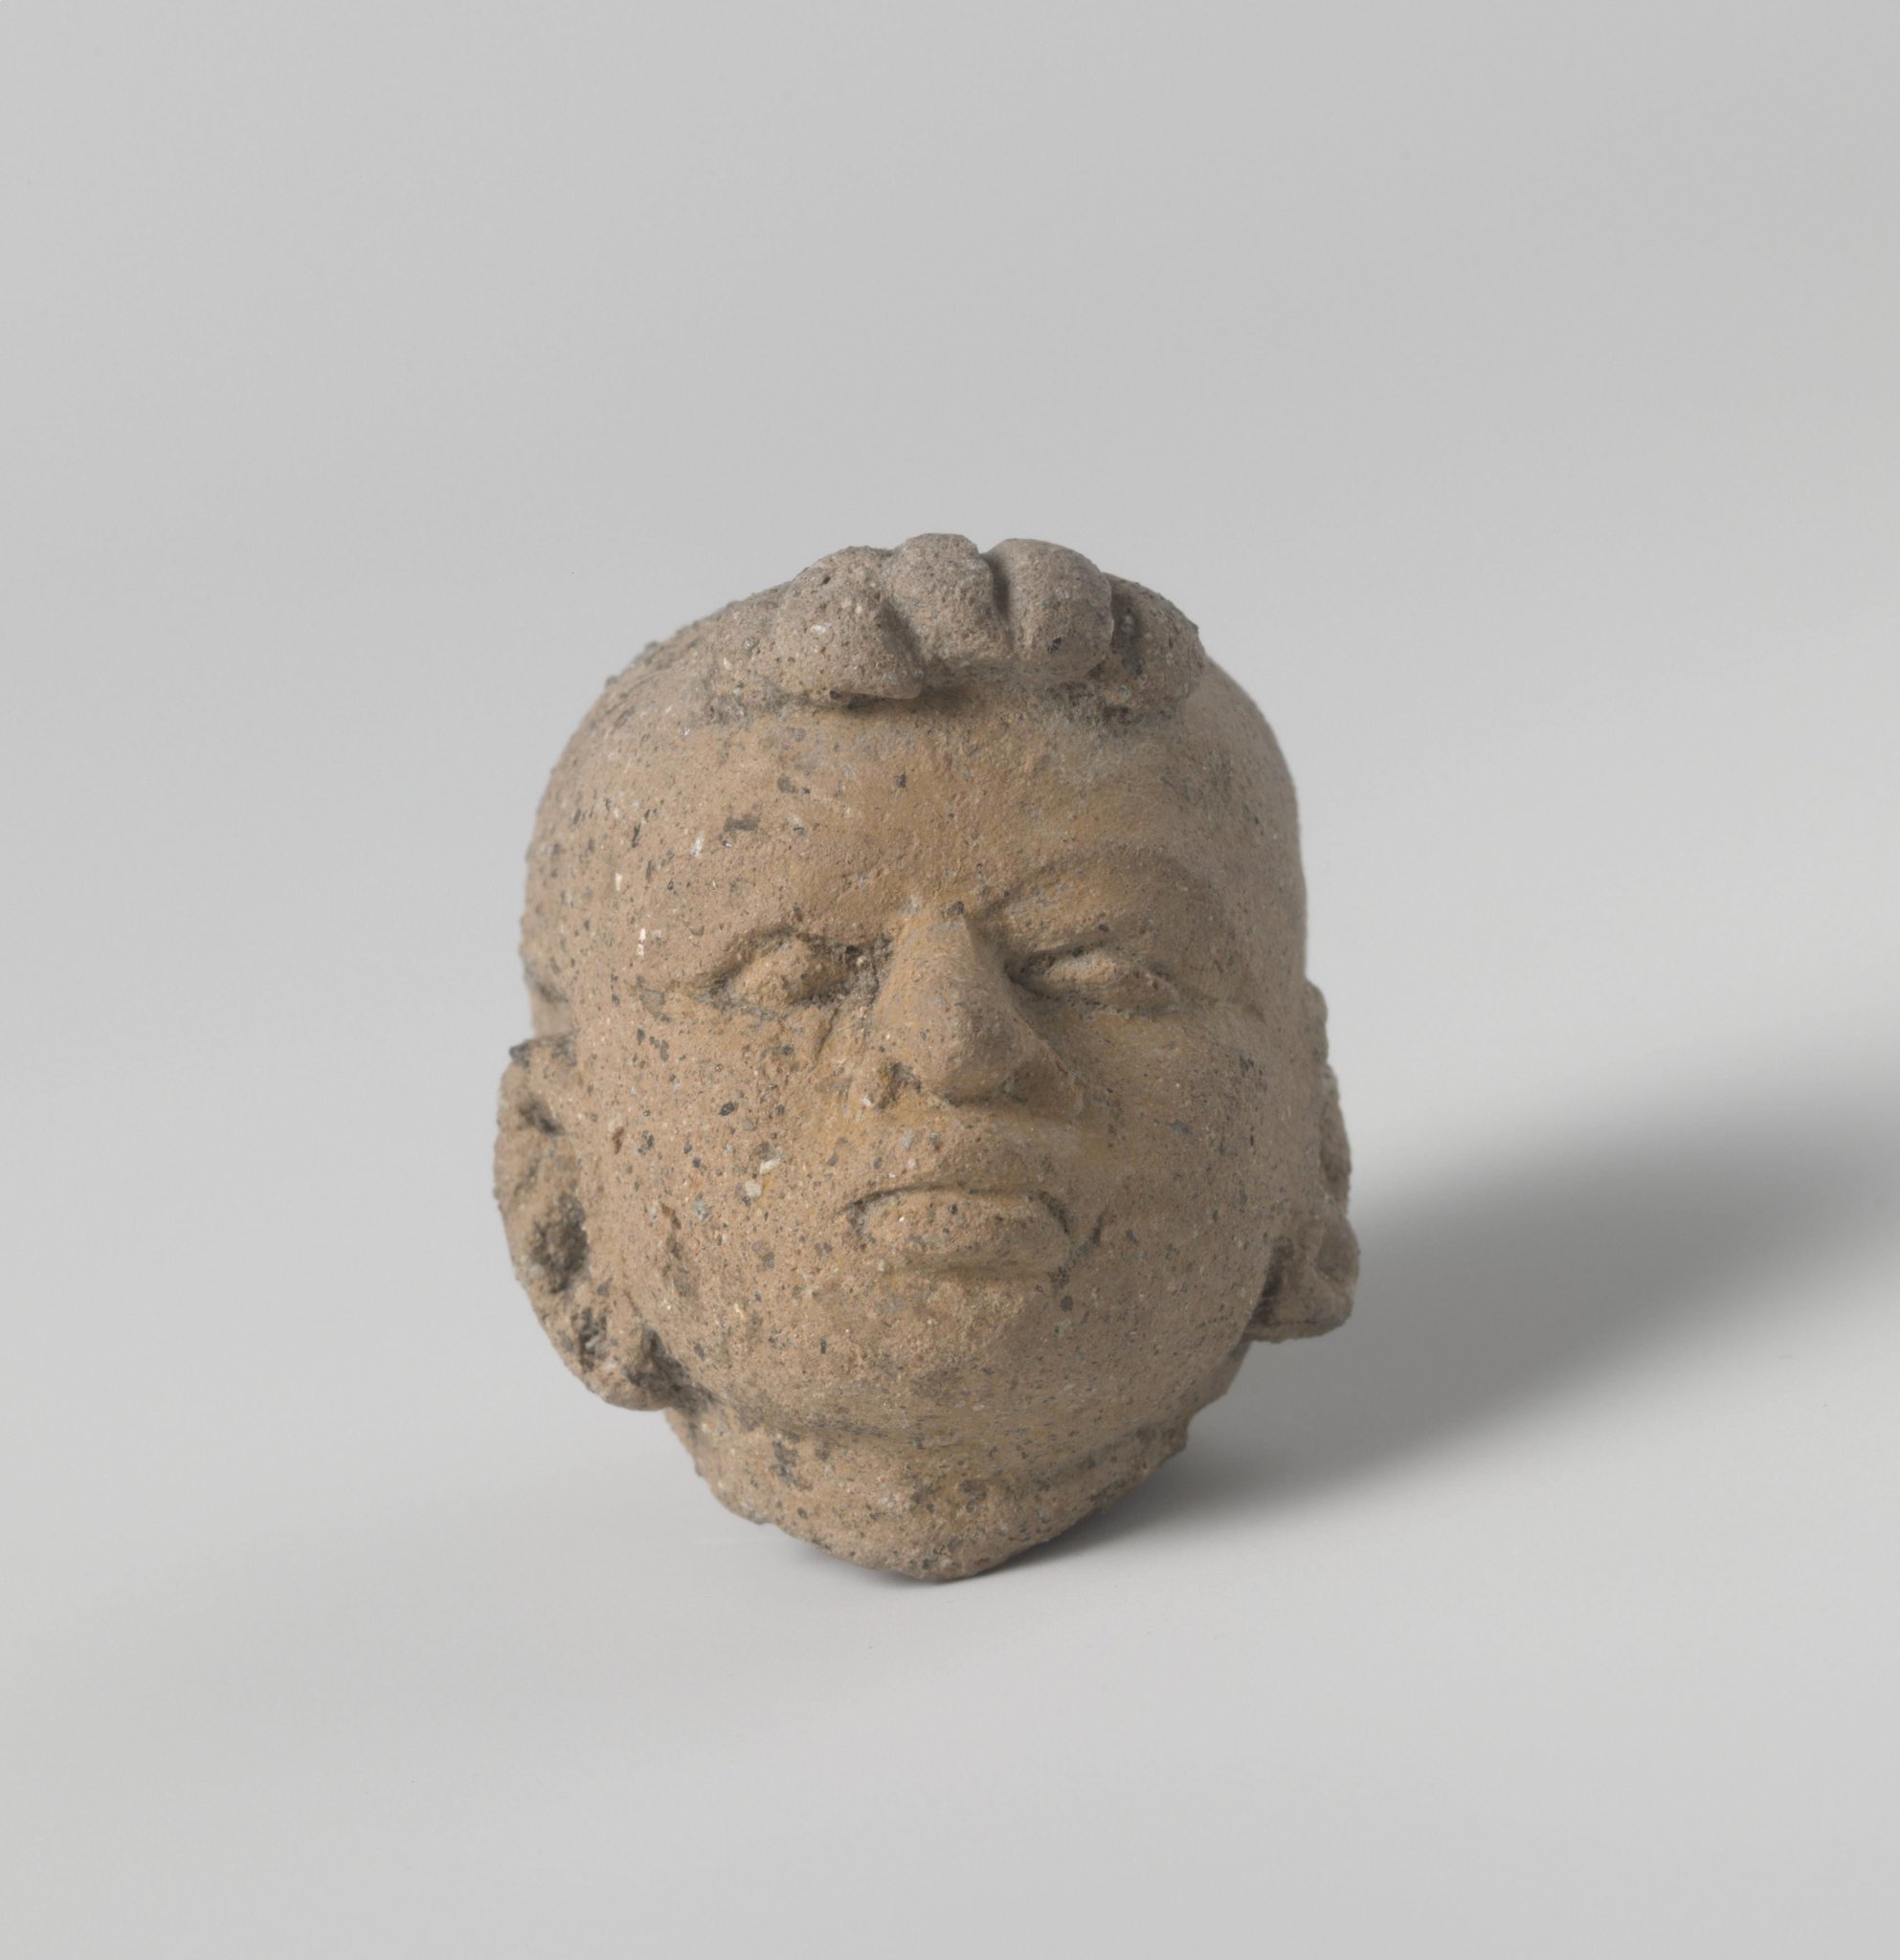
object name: sculpture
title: Sculptuur voorstellend jongenskop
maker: Anonymous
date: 1300-1500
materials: terracotta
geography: java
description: Boy's head. Indonesia, East Java, Trowulan Mojopahit period, 14th - 15th century. Terracotta. Given by Mrs E.M. Refuge-Roetert Steenbruggen.